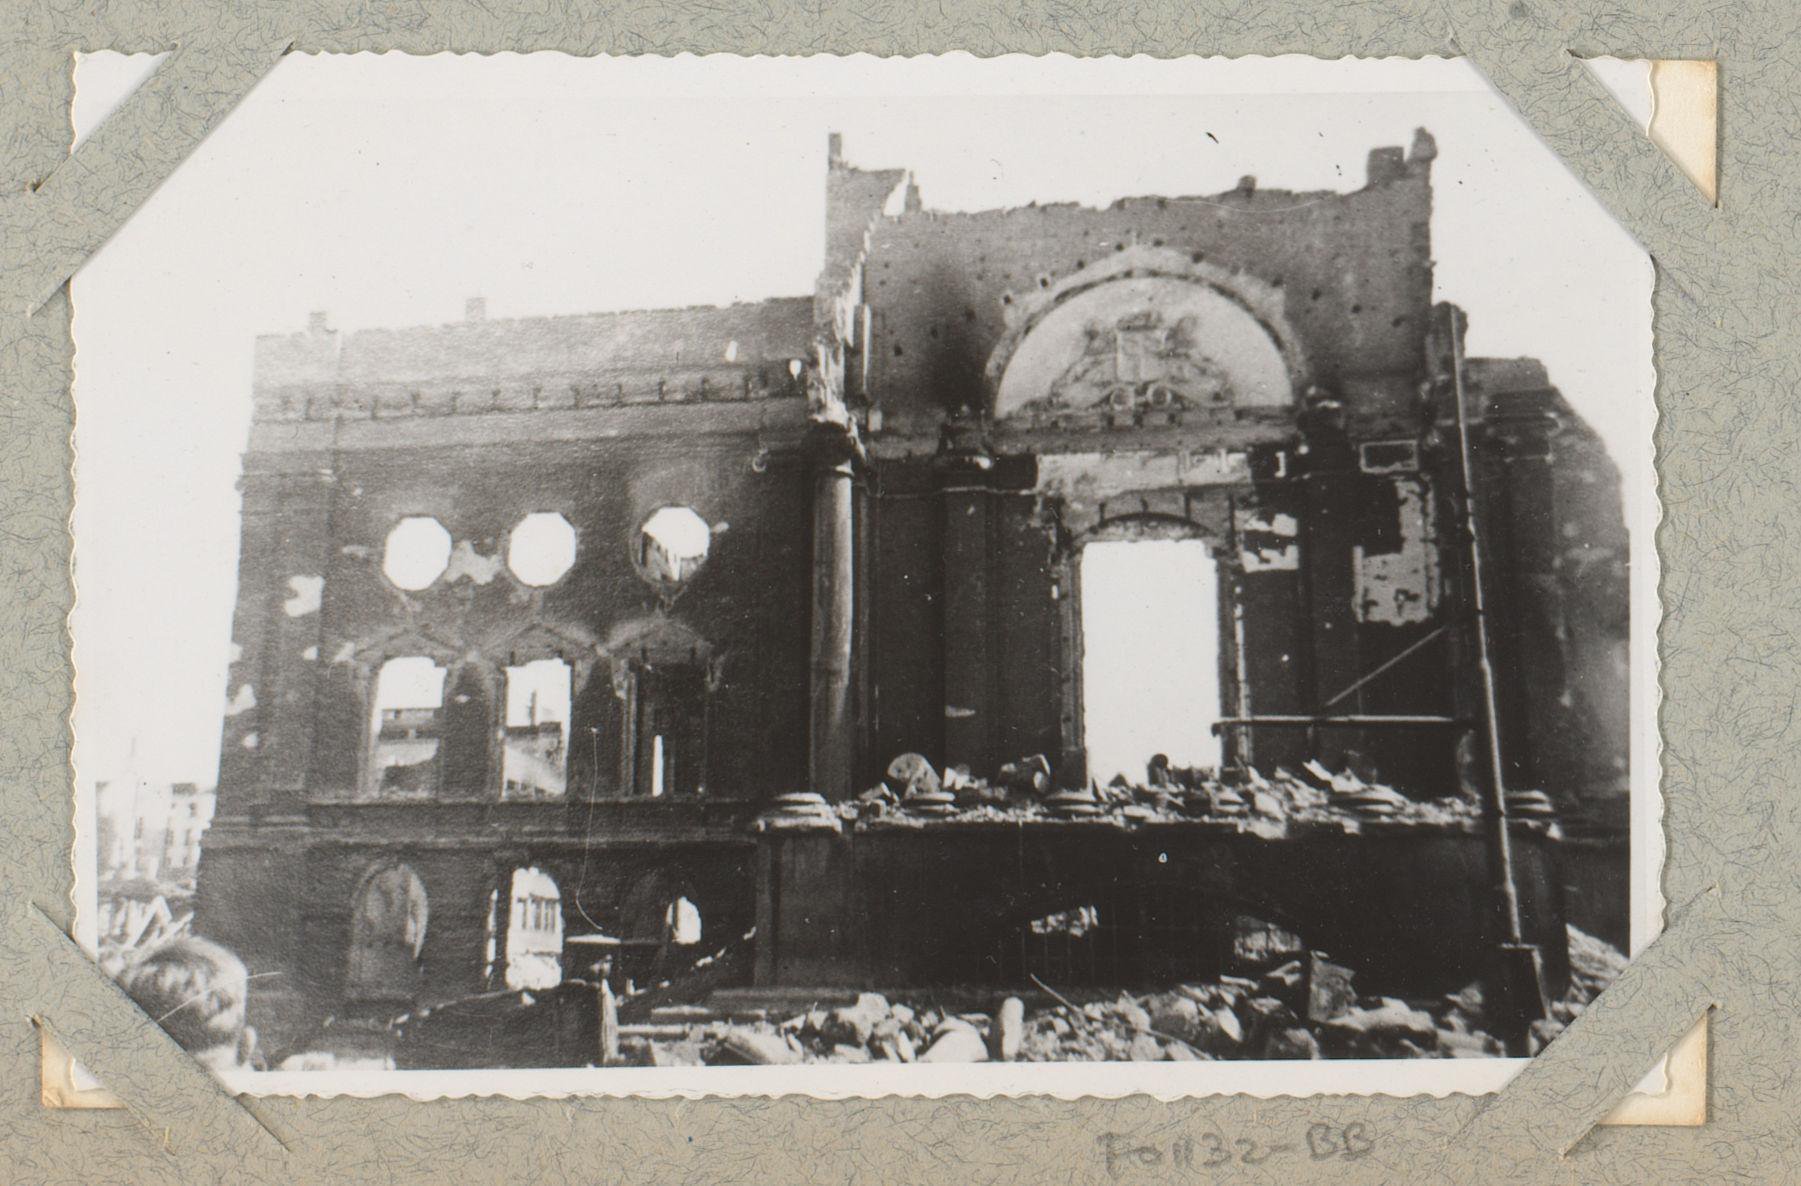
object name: photograph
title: Ruïne van een gebouw te Rotterdam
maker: j. nolte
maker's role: fotograaf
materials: photographic support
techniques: gelatin silver print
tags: devastated, ruined place or city (~ warfare), ruin of a dwelling, house, castle, etc., rotterdam, rotterdam blitz